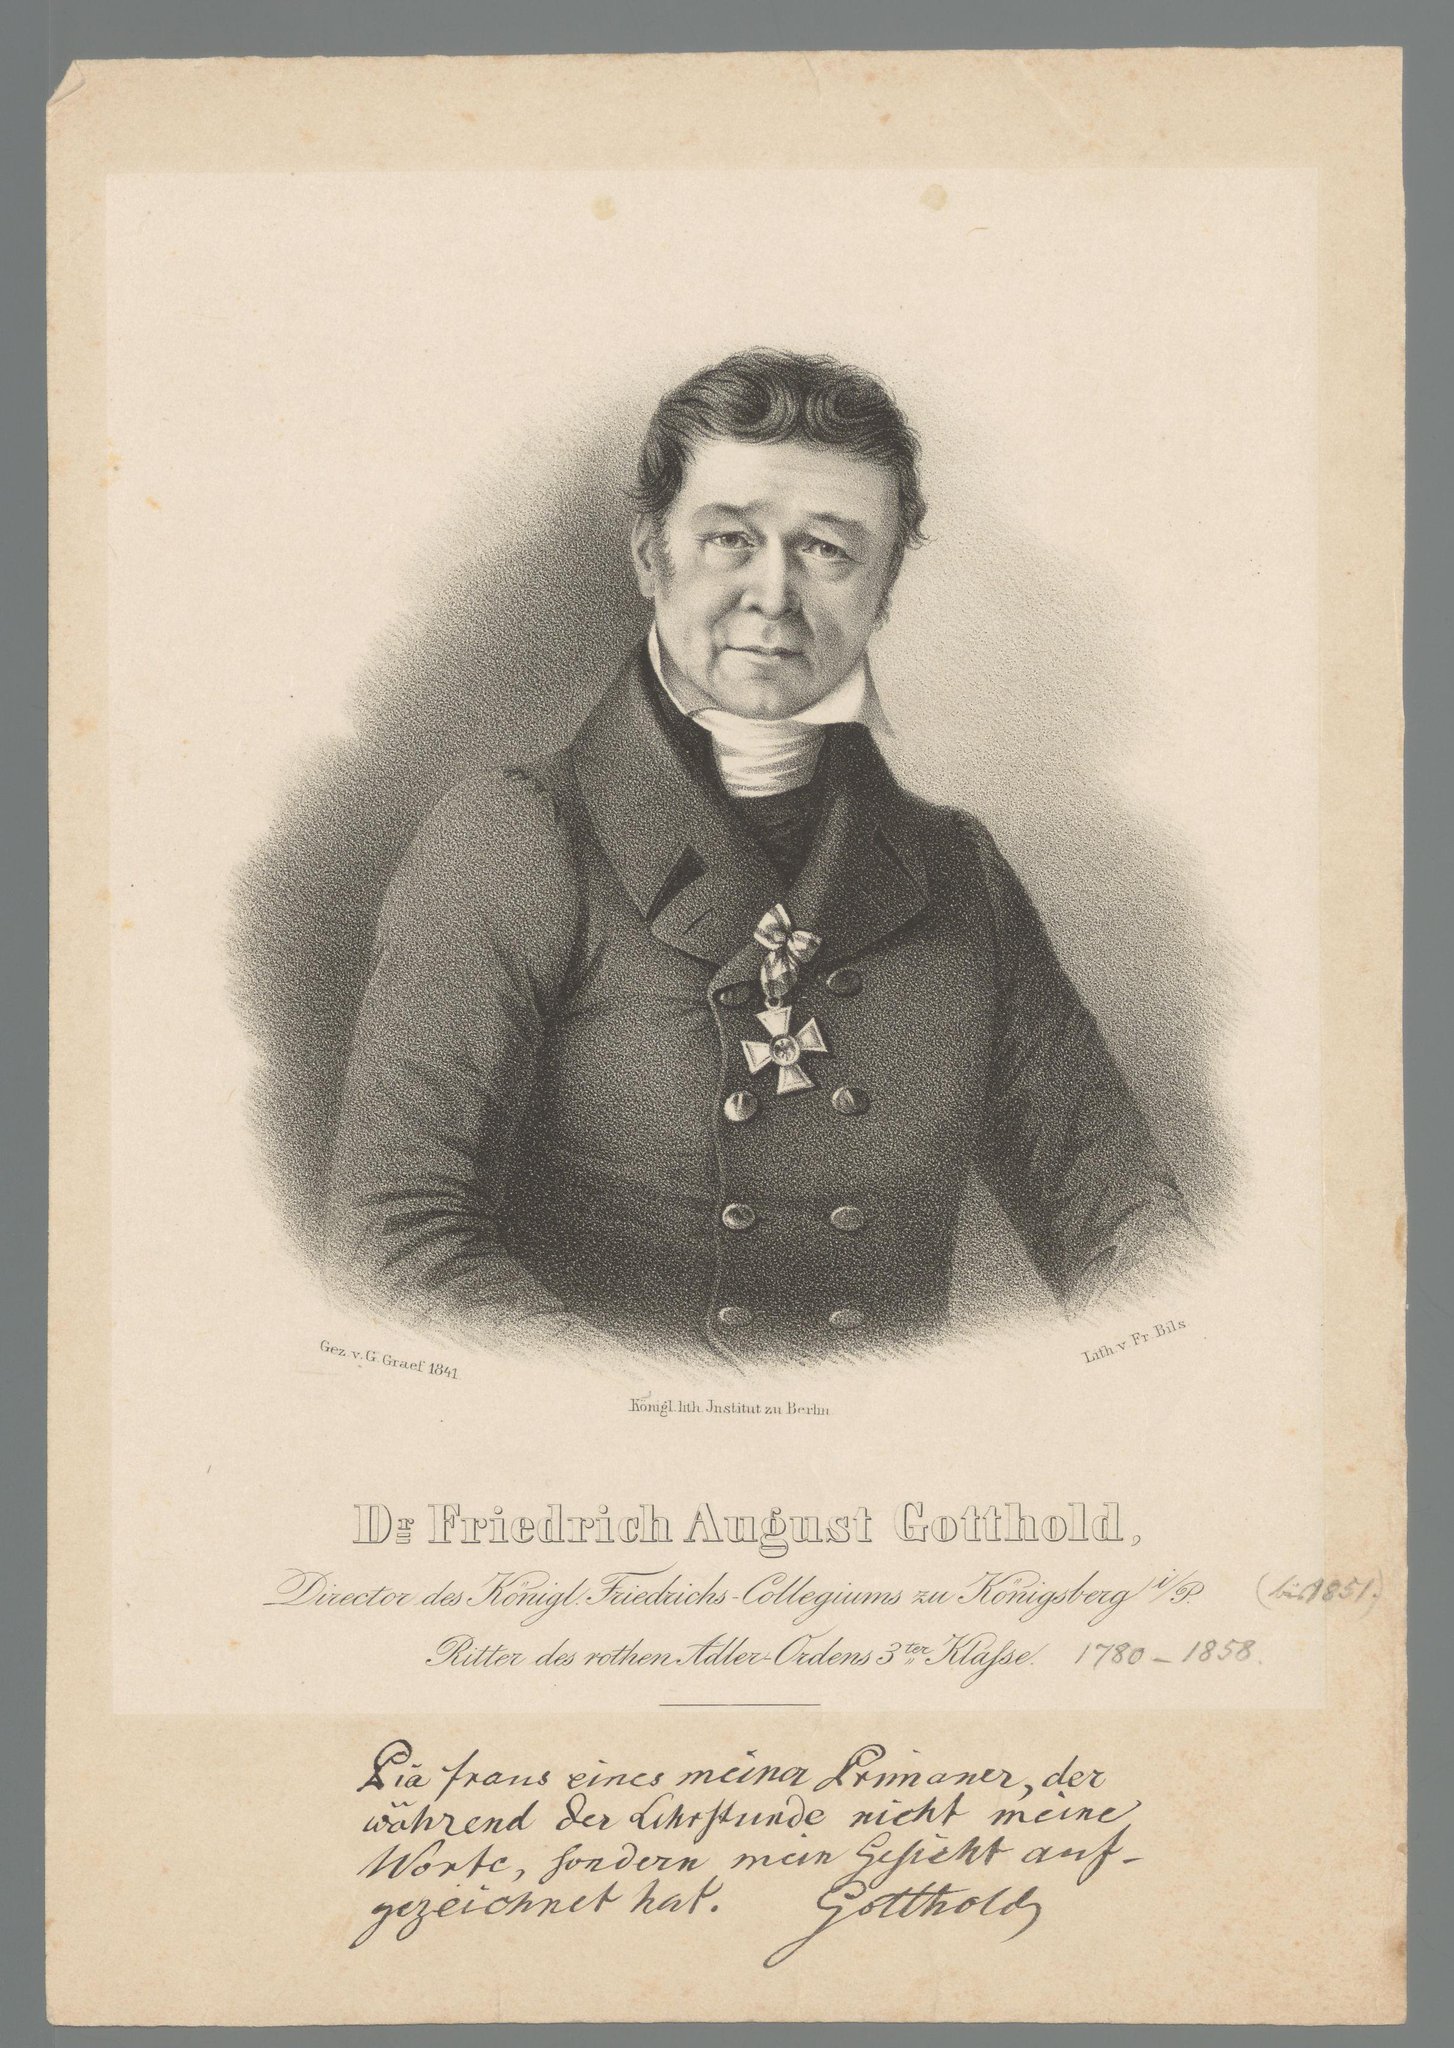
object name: print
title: Portret van Friedrich August Gotthold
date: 1841-1853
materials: paper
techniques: lithograph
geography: berlin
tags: adult man, historical persons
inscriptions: collector's mark: Lugt 2228